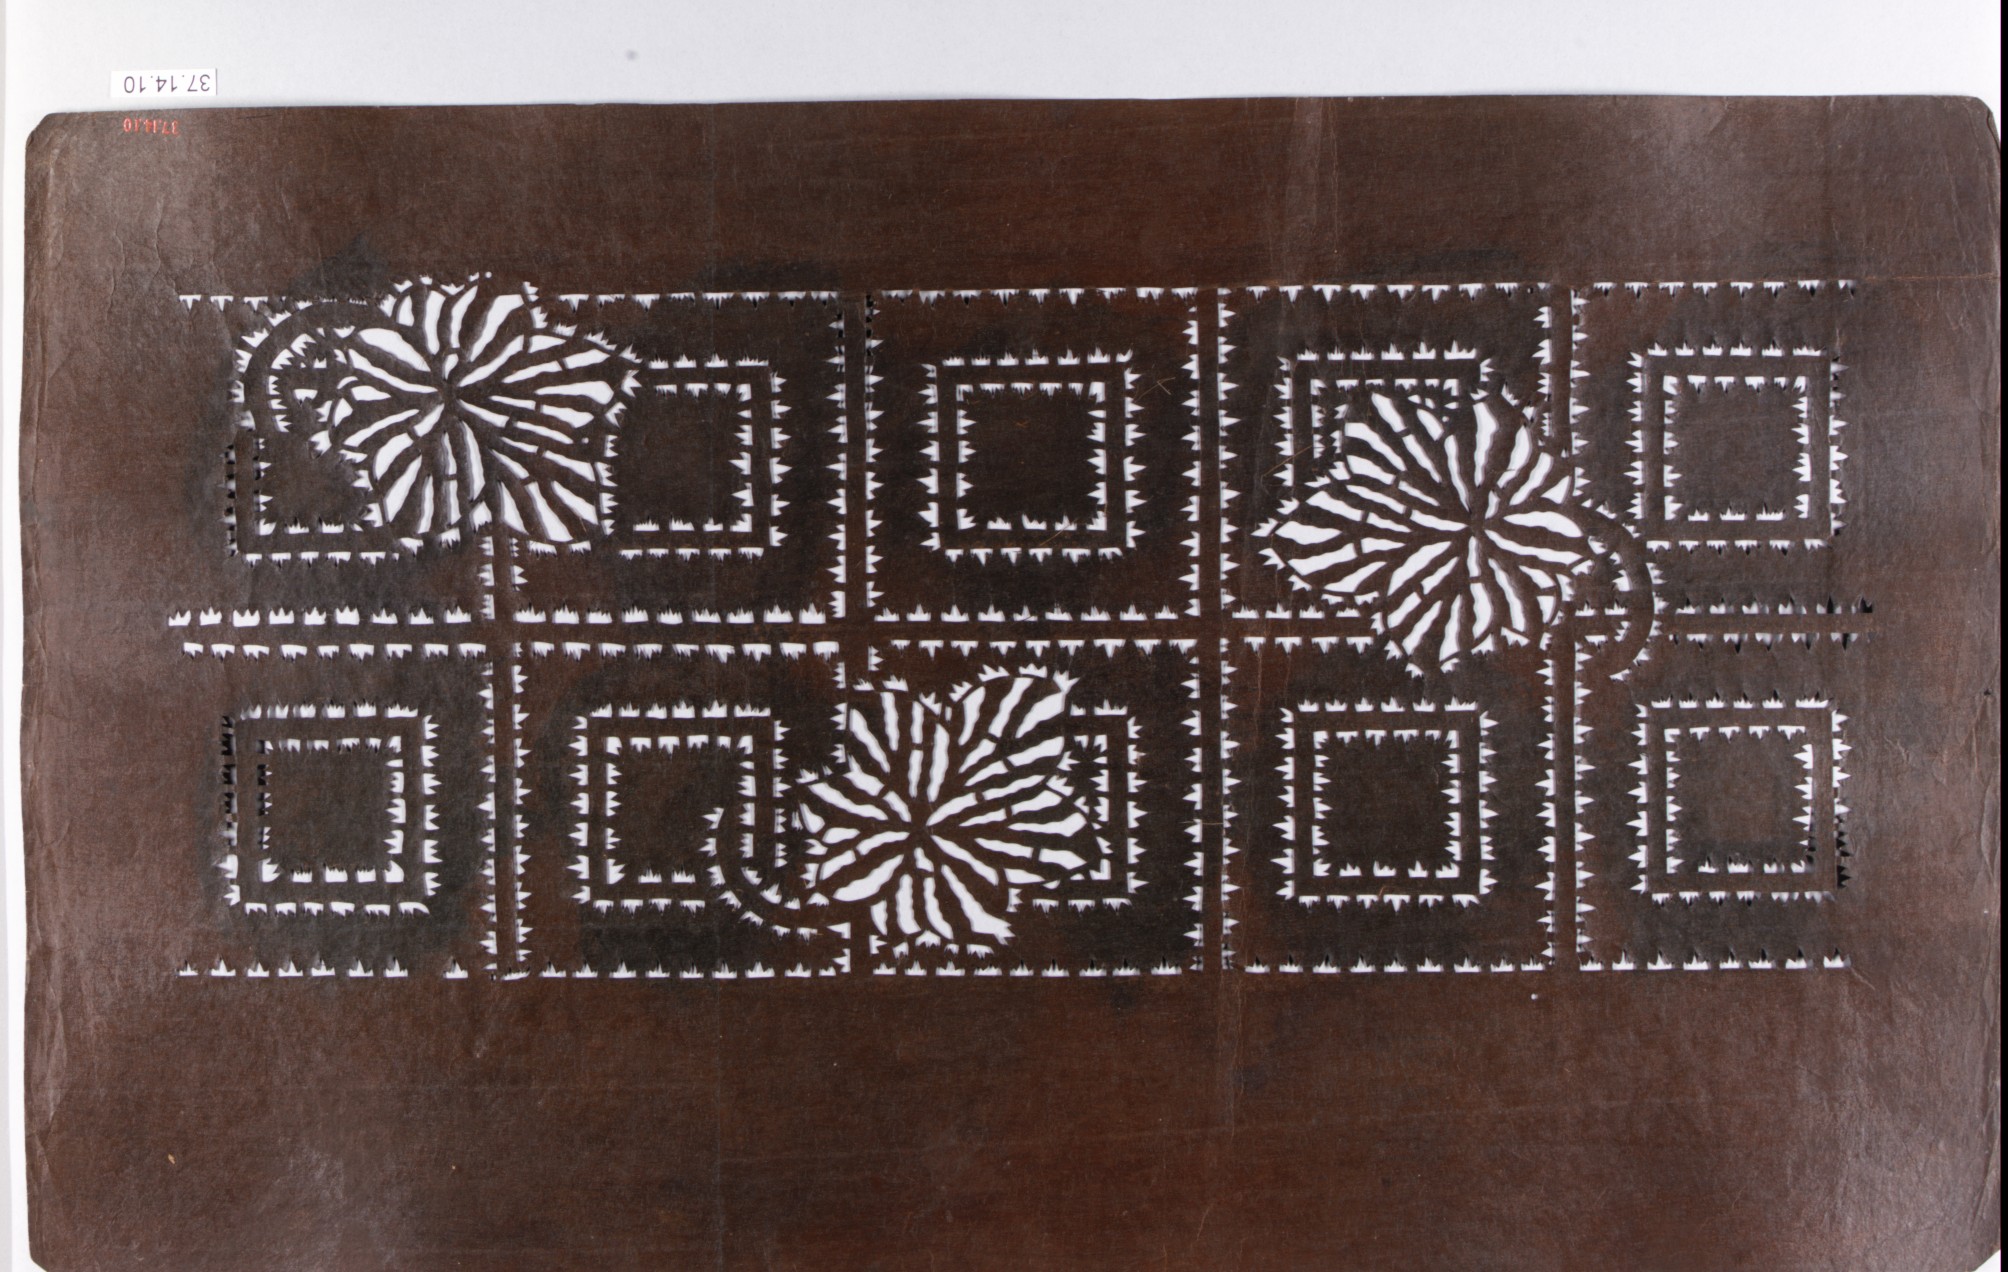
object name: stencil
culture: japanese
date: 1801-1833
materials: paper